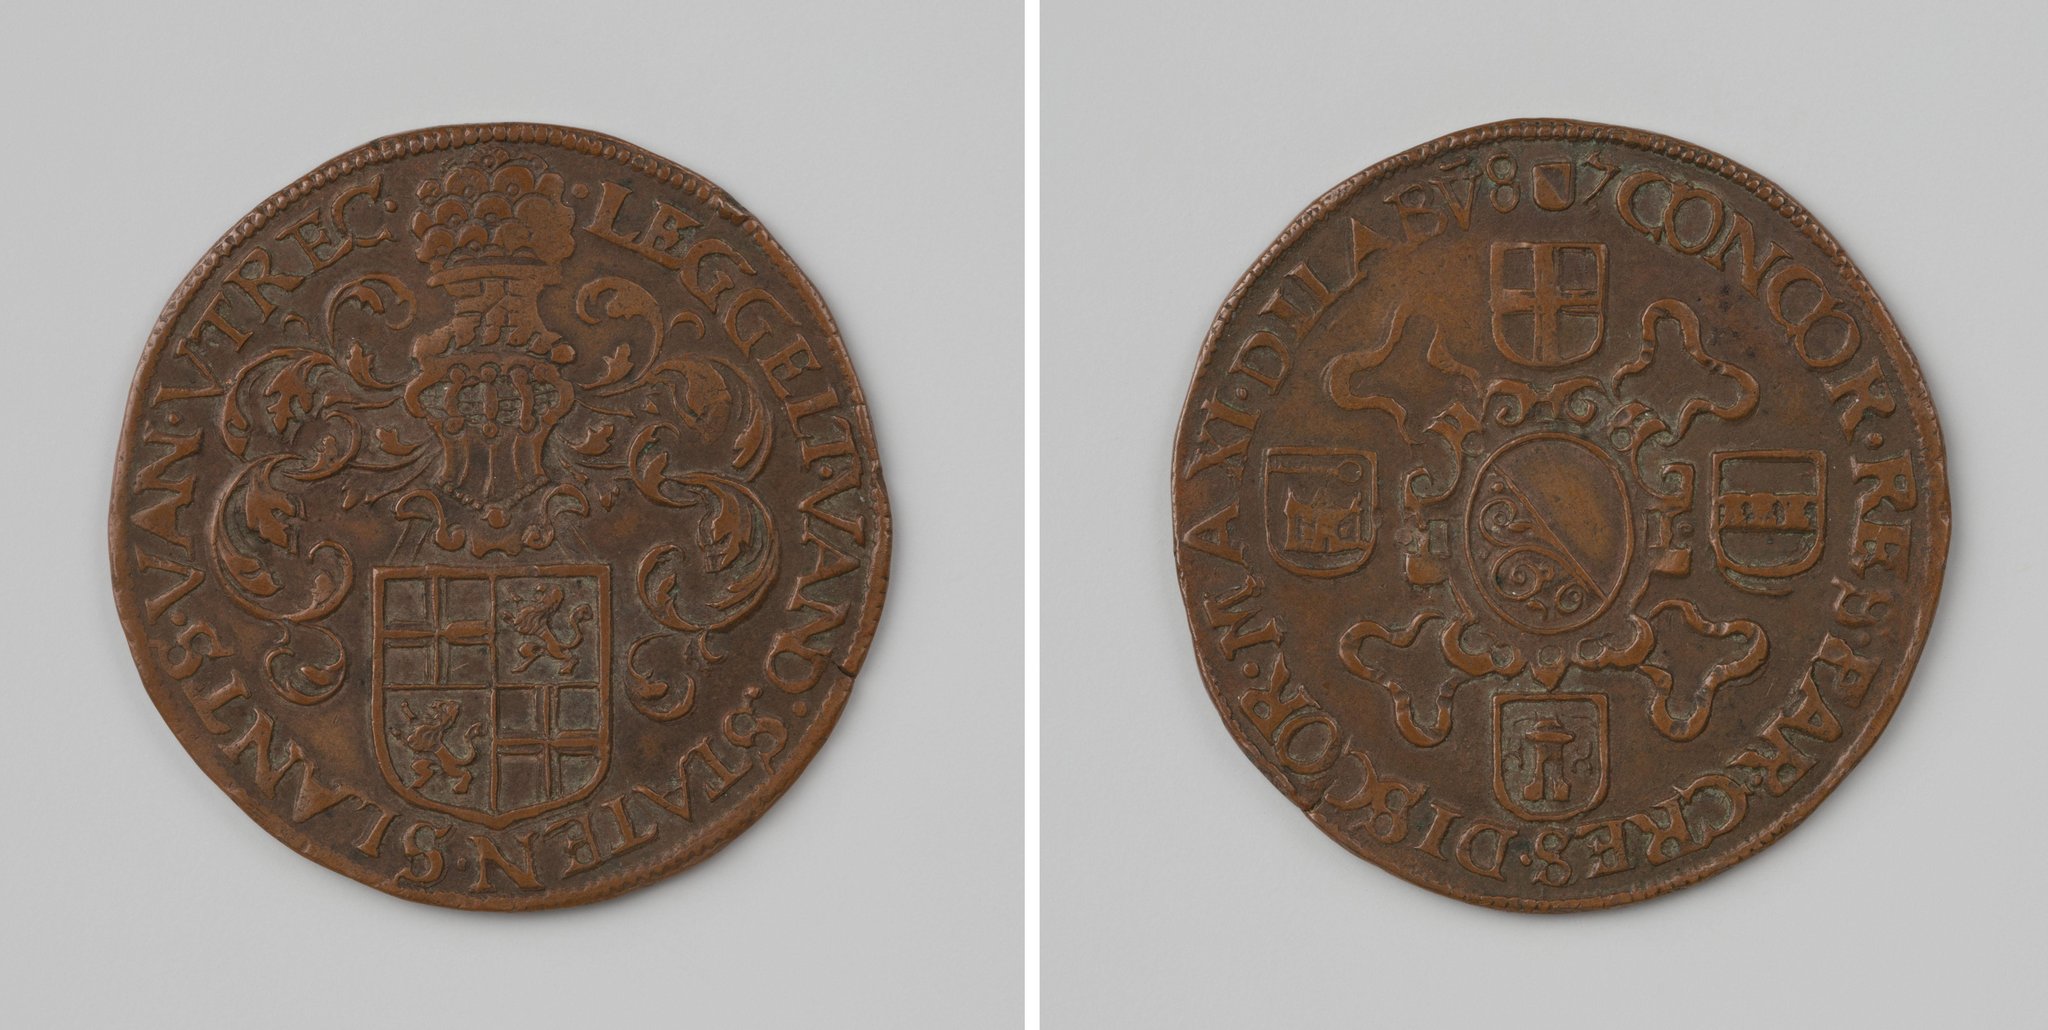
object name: jeton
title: Staten van Utrecht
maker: Anonymous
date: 1587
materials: copper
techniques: striking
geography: utrecht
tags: utrecht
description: Koperen penning. Voorzijde: gehelmd wapenschild onder vaas met bloemen binnen omschrift. Keerzijde: wapenschild op versierd cartouche, omgeven door vier wapenschilden binnen omschrift